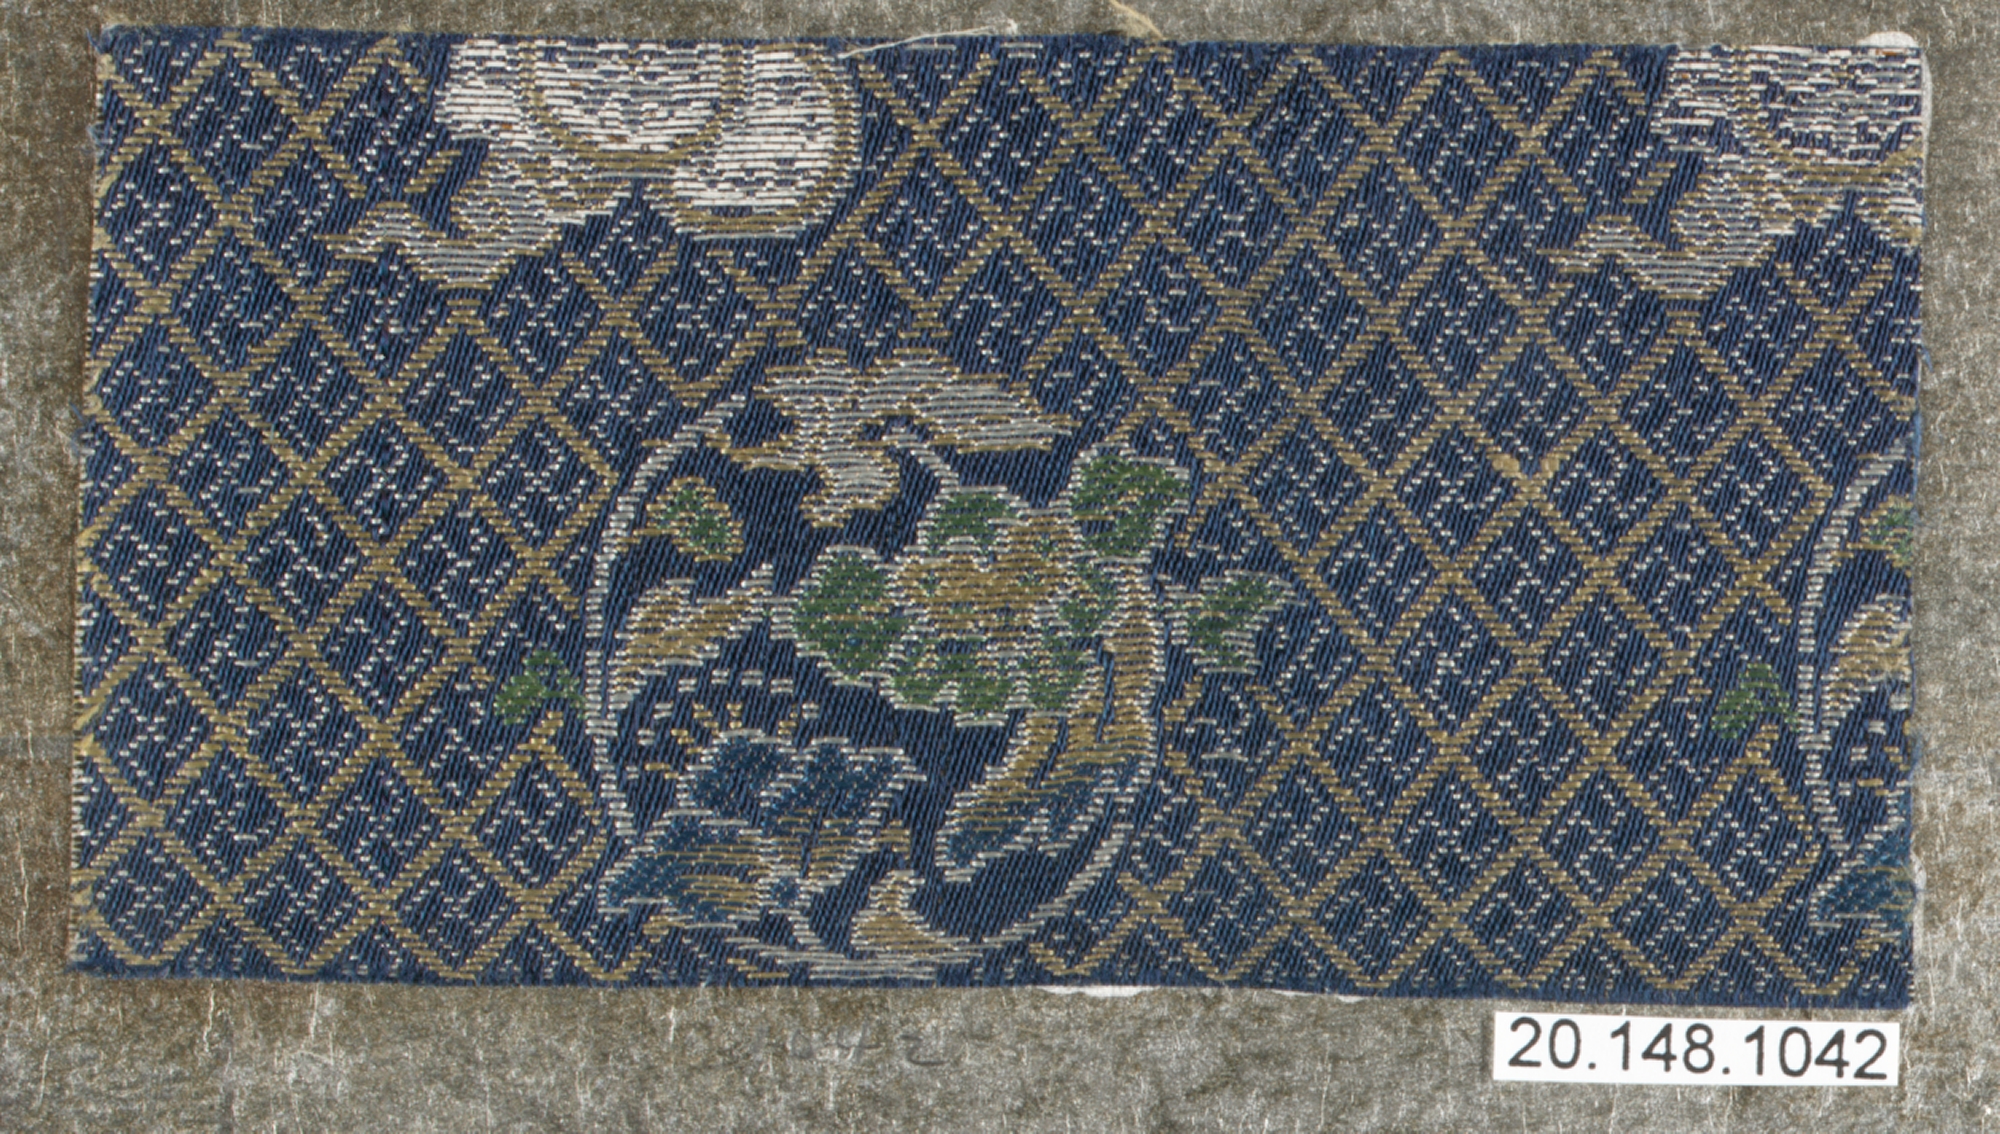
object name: piece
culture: japanese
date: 1801-1900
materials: silk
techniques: compound weave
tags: flowers